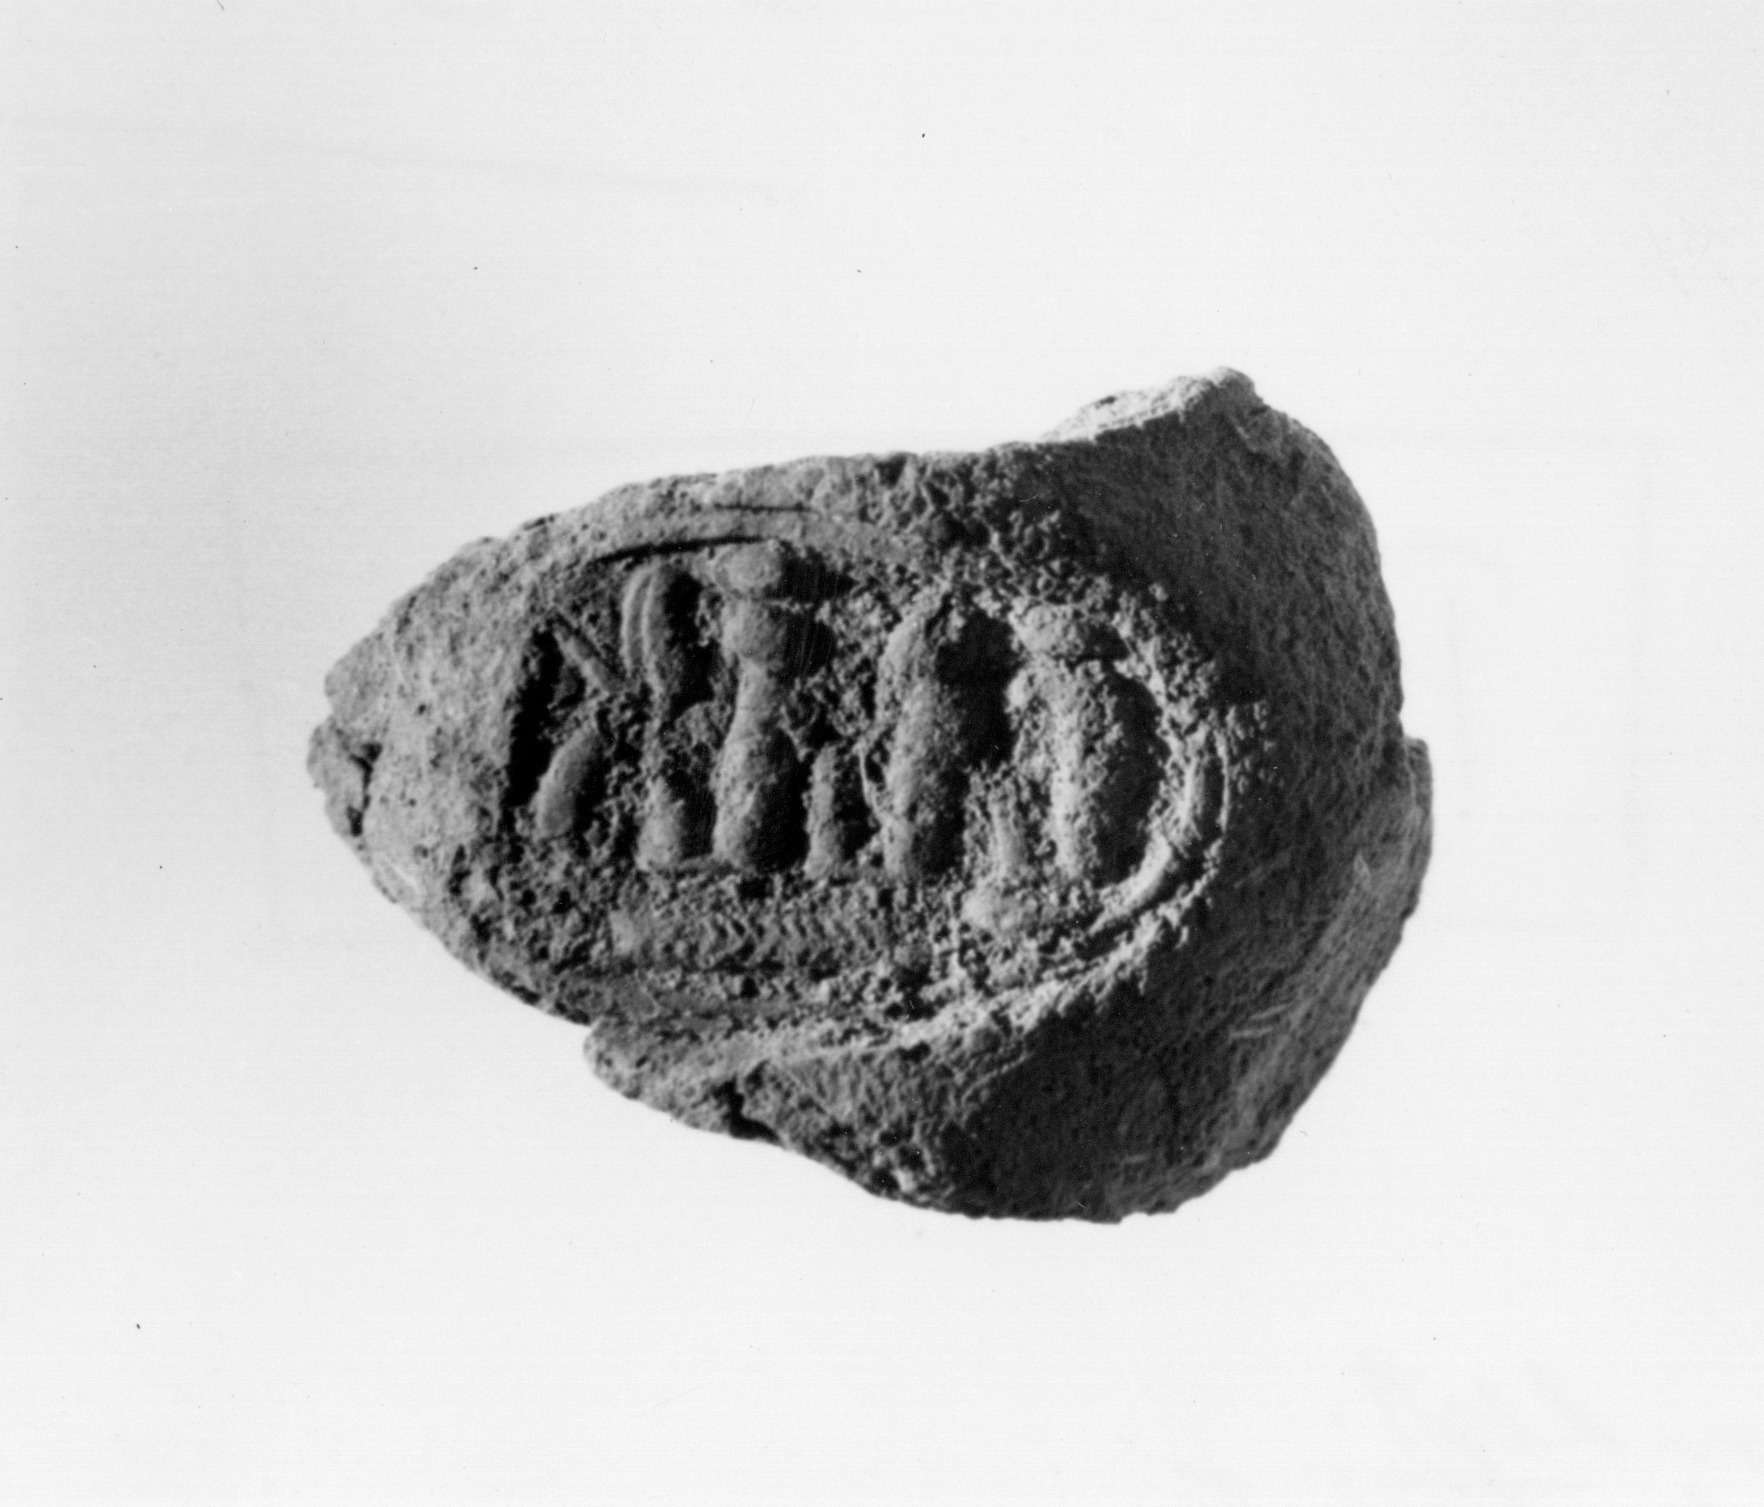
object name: sealing, nebmaatre, amenhotep iii, thoth, ptah, re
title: Document Sealing With the Throne Name of Amenhotep III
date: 1390-1352 BCE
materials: mud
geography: egypt